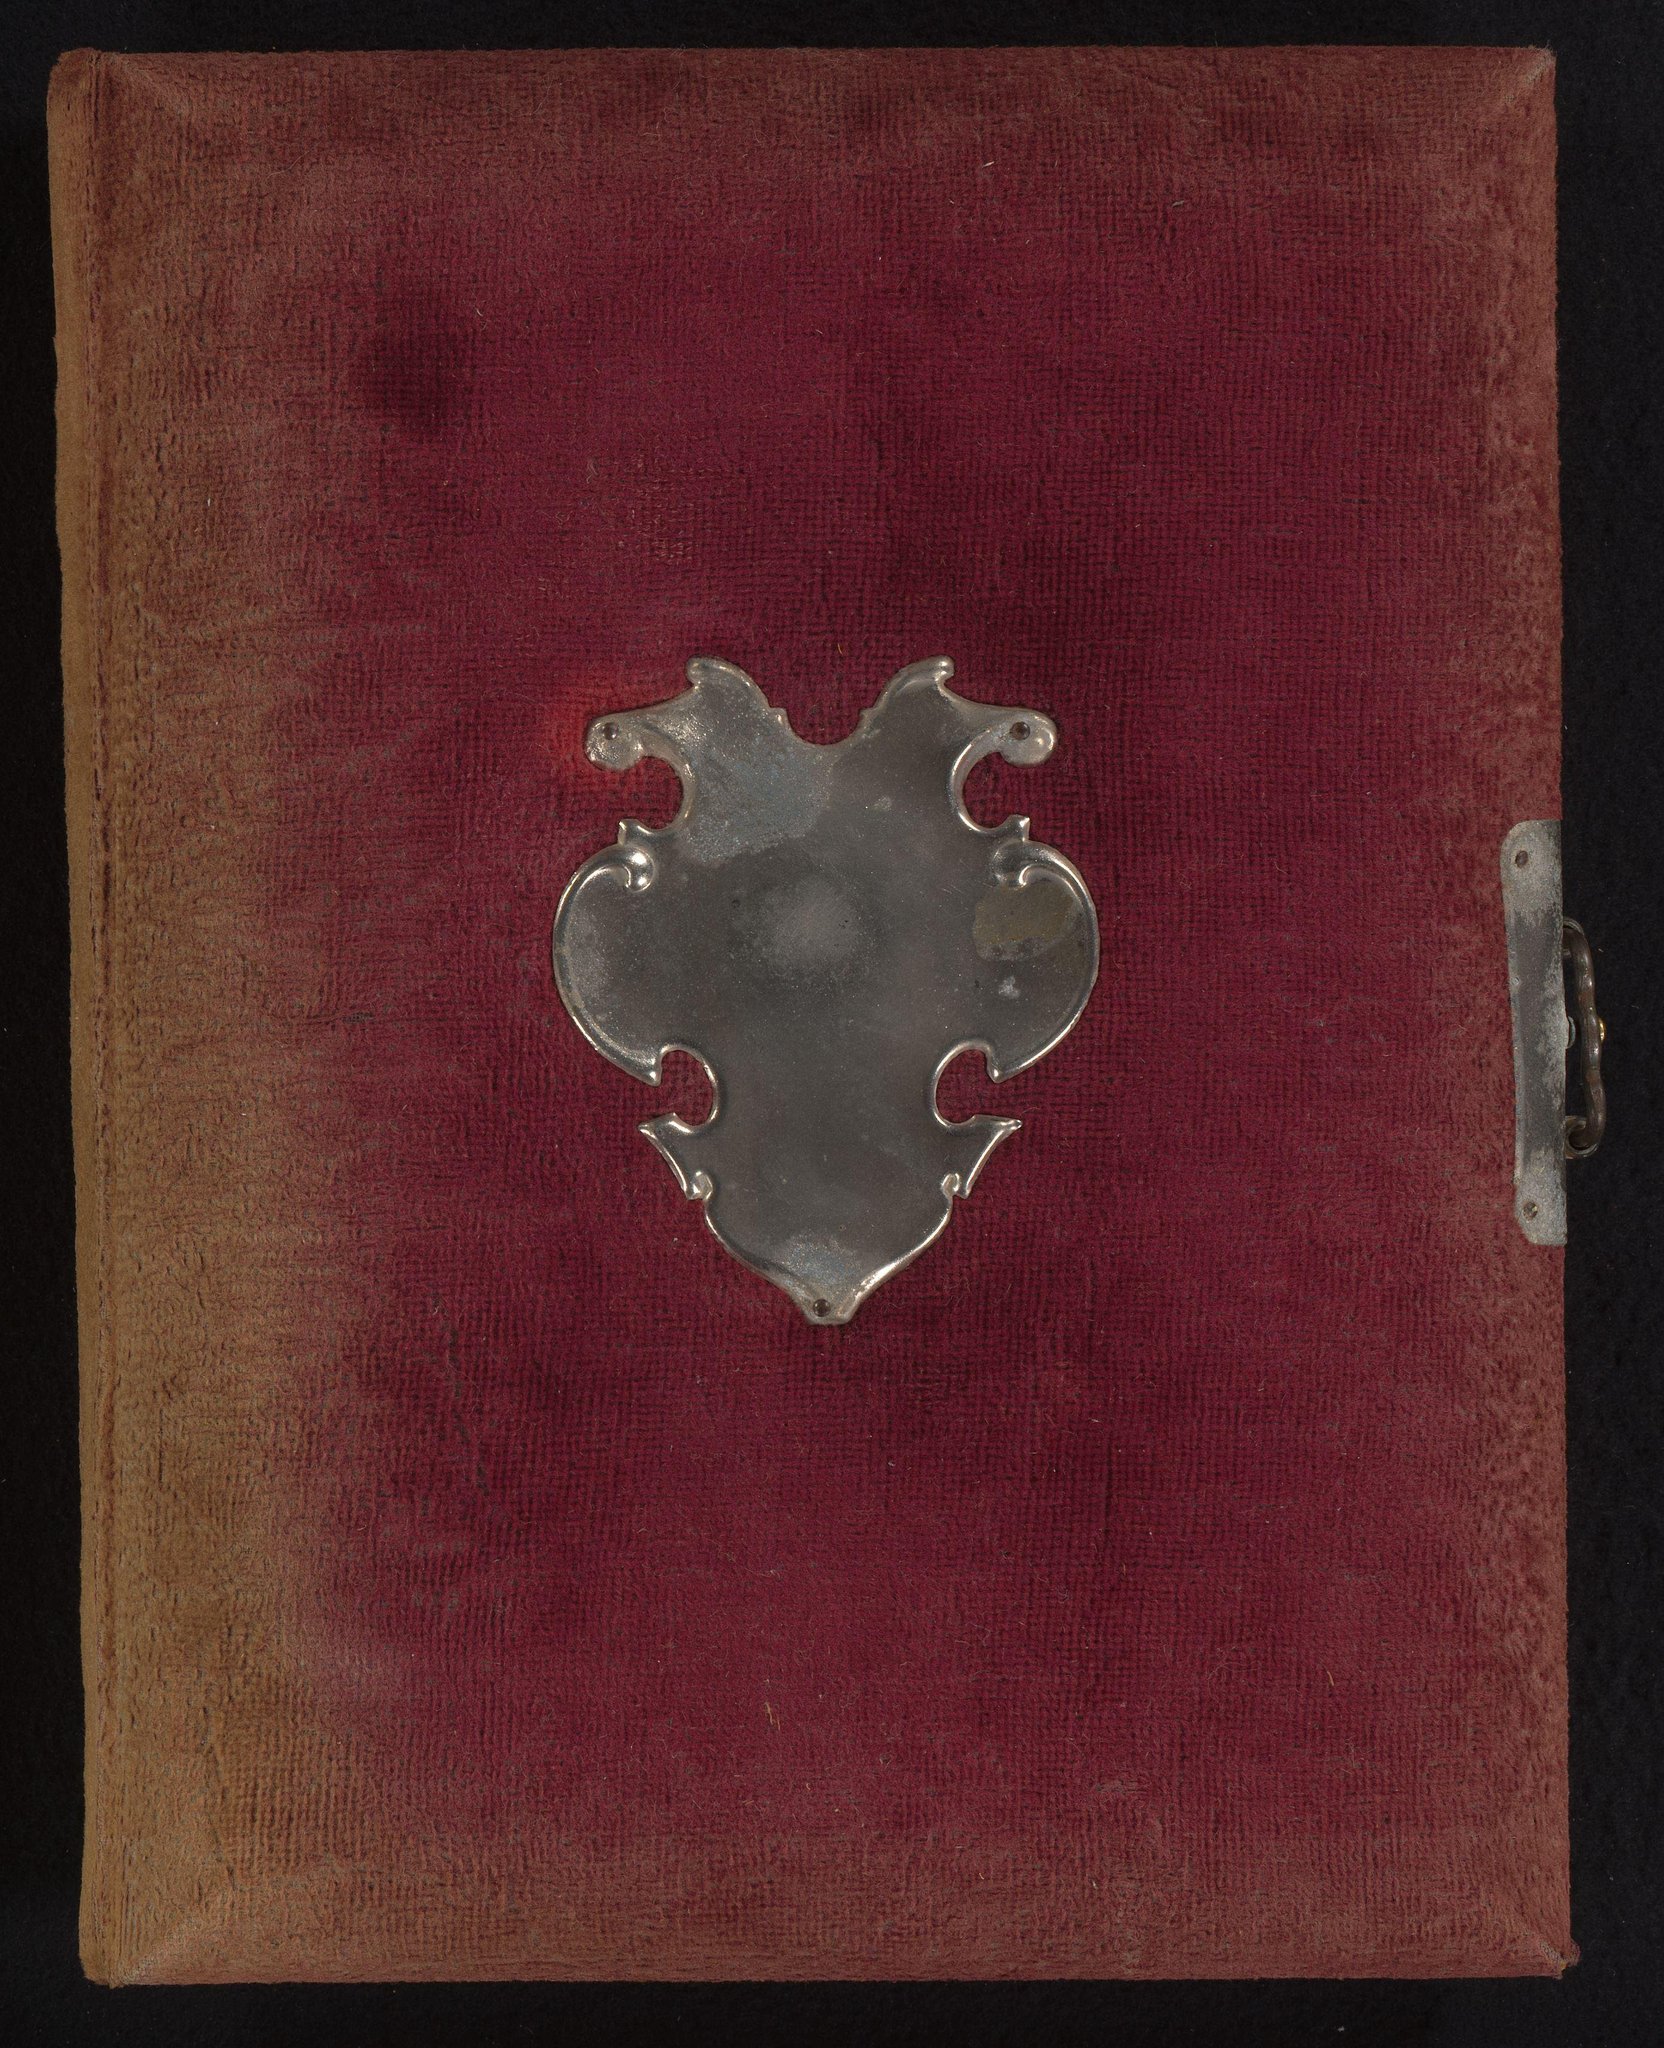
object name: slip in album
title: West-Fries familiealbum met 23 foto's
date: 1870-1920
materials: cardboard, metal, paper, photographic support, textile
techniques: albumen print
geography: netherlands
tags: historical persons - bb - woman, child, historical persons, folk costume, regional costume, den helder, enkhuizen, utrecht, amsterdam, hoorn (north holland)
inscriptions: annotation: ‘ABK/ AKK’, collector's mark: ‘DIENST/ VERSPREIDE/ RIJKSKOLLEKTIES/ (...) A 703’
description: Fotoalbum met 18 pagina's met in totaal 23 cartes-de-visite in met gouden lijnen omkaderde passe-partouts. Niet alle passe-partouts in het album zijn gevuld. Afgebeeld zijn portretten van mannen, vrouwen en kinderen, waarvan sommigen in West-Friese klederdracht. De foto's zijn gemaakt door diverse fotografen. Het merendeel van de foto's is gemaakt door J.L.T. Huijsen (11) uit Hoorn.